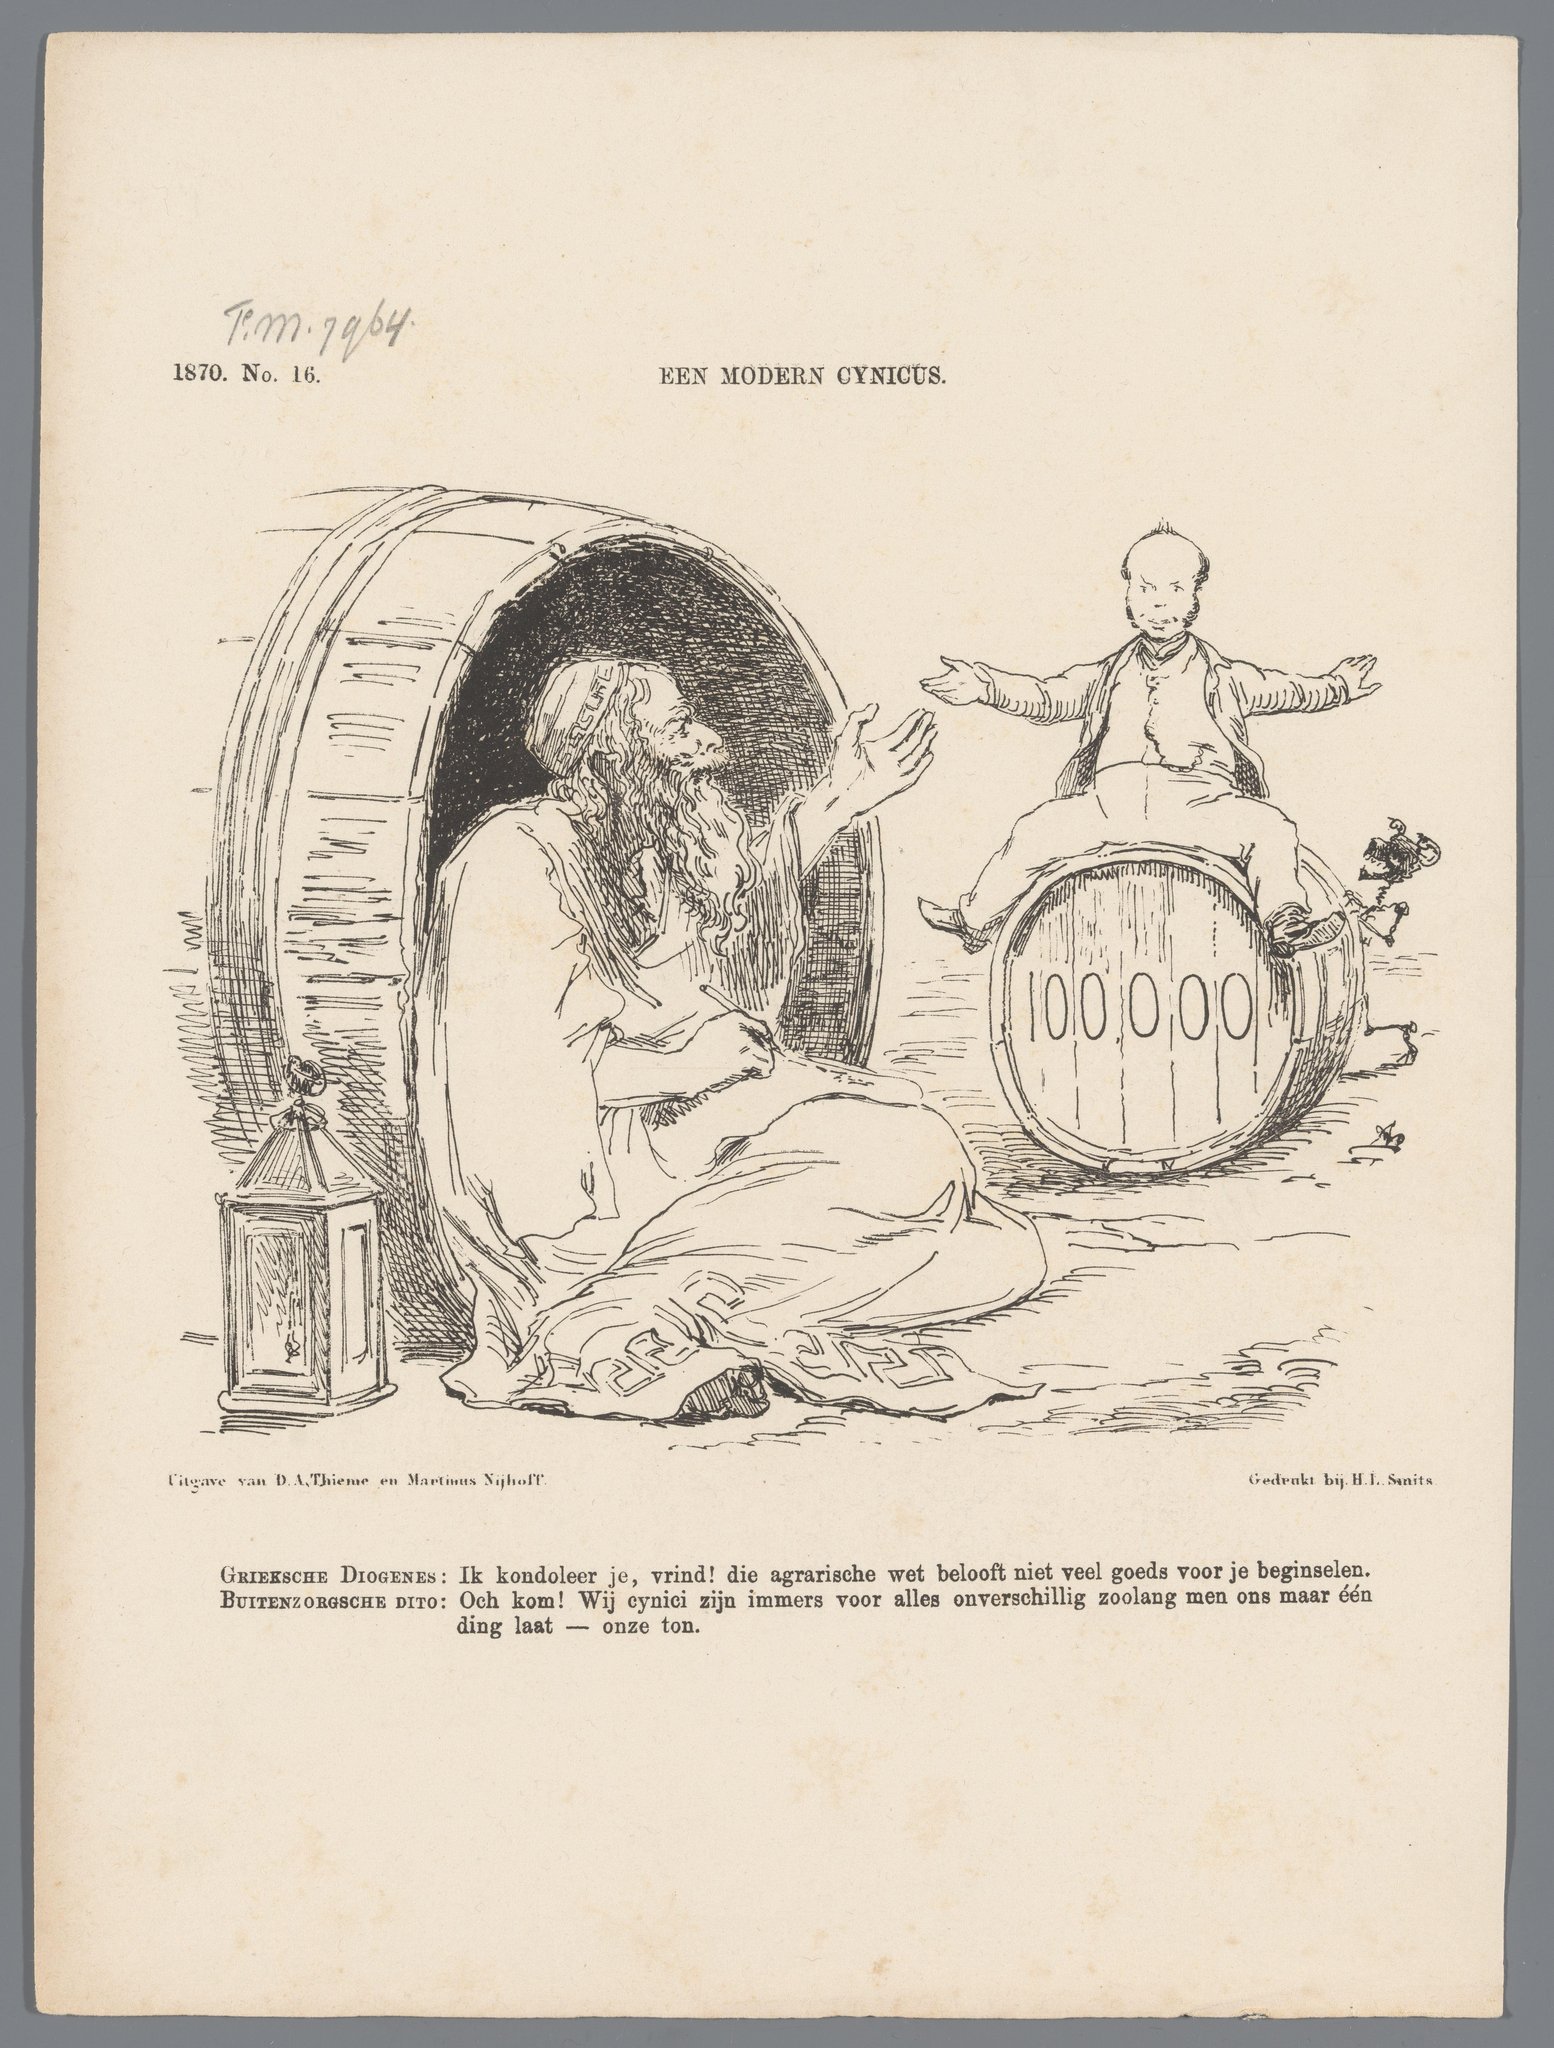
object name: cartoon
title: Een modern cynicus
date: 1870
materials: paper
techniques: lithograph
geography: arnhem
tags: batavia, non-aggressive activities of diogenes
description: Spotprent op gouverneur-generaal Mijer die op een ton (100.000 gulden) zit, op de voorgrond Diogenes wonend in een houten ton. Plaat verschenen bij het weekblad De Nederlandsche Spectator, nr. 16, 1870.